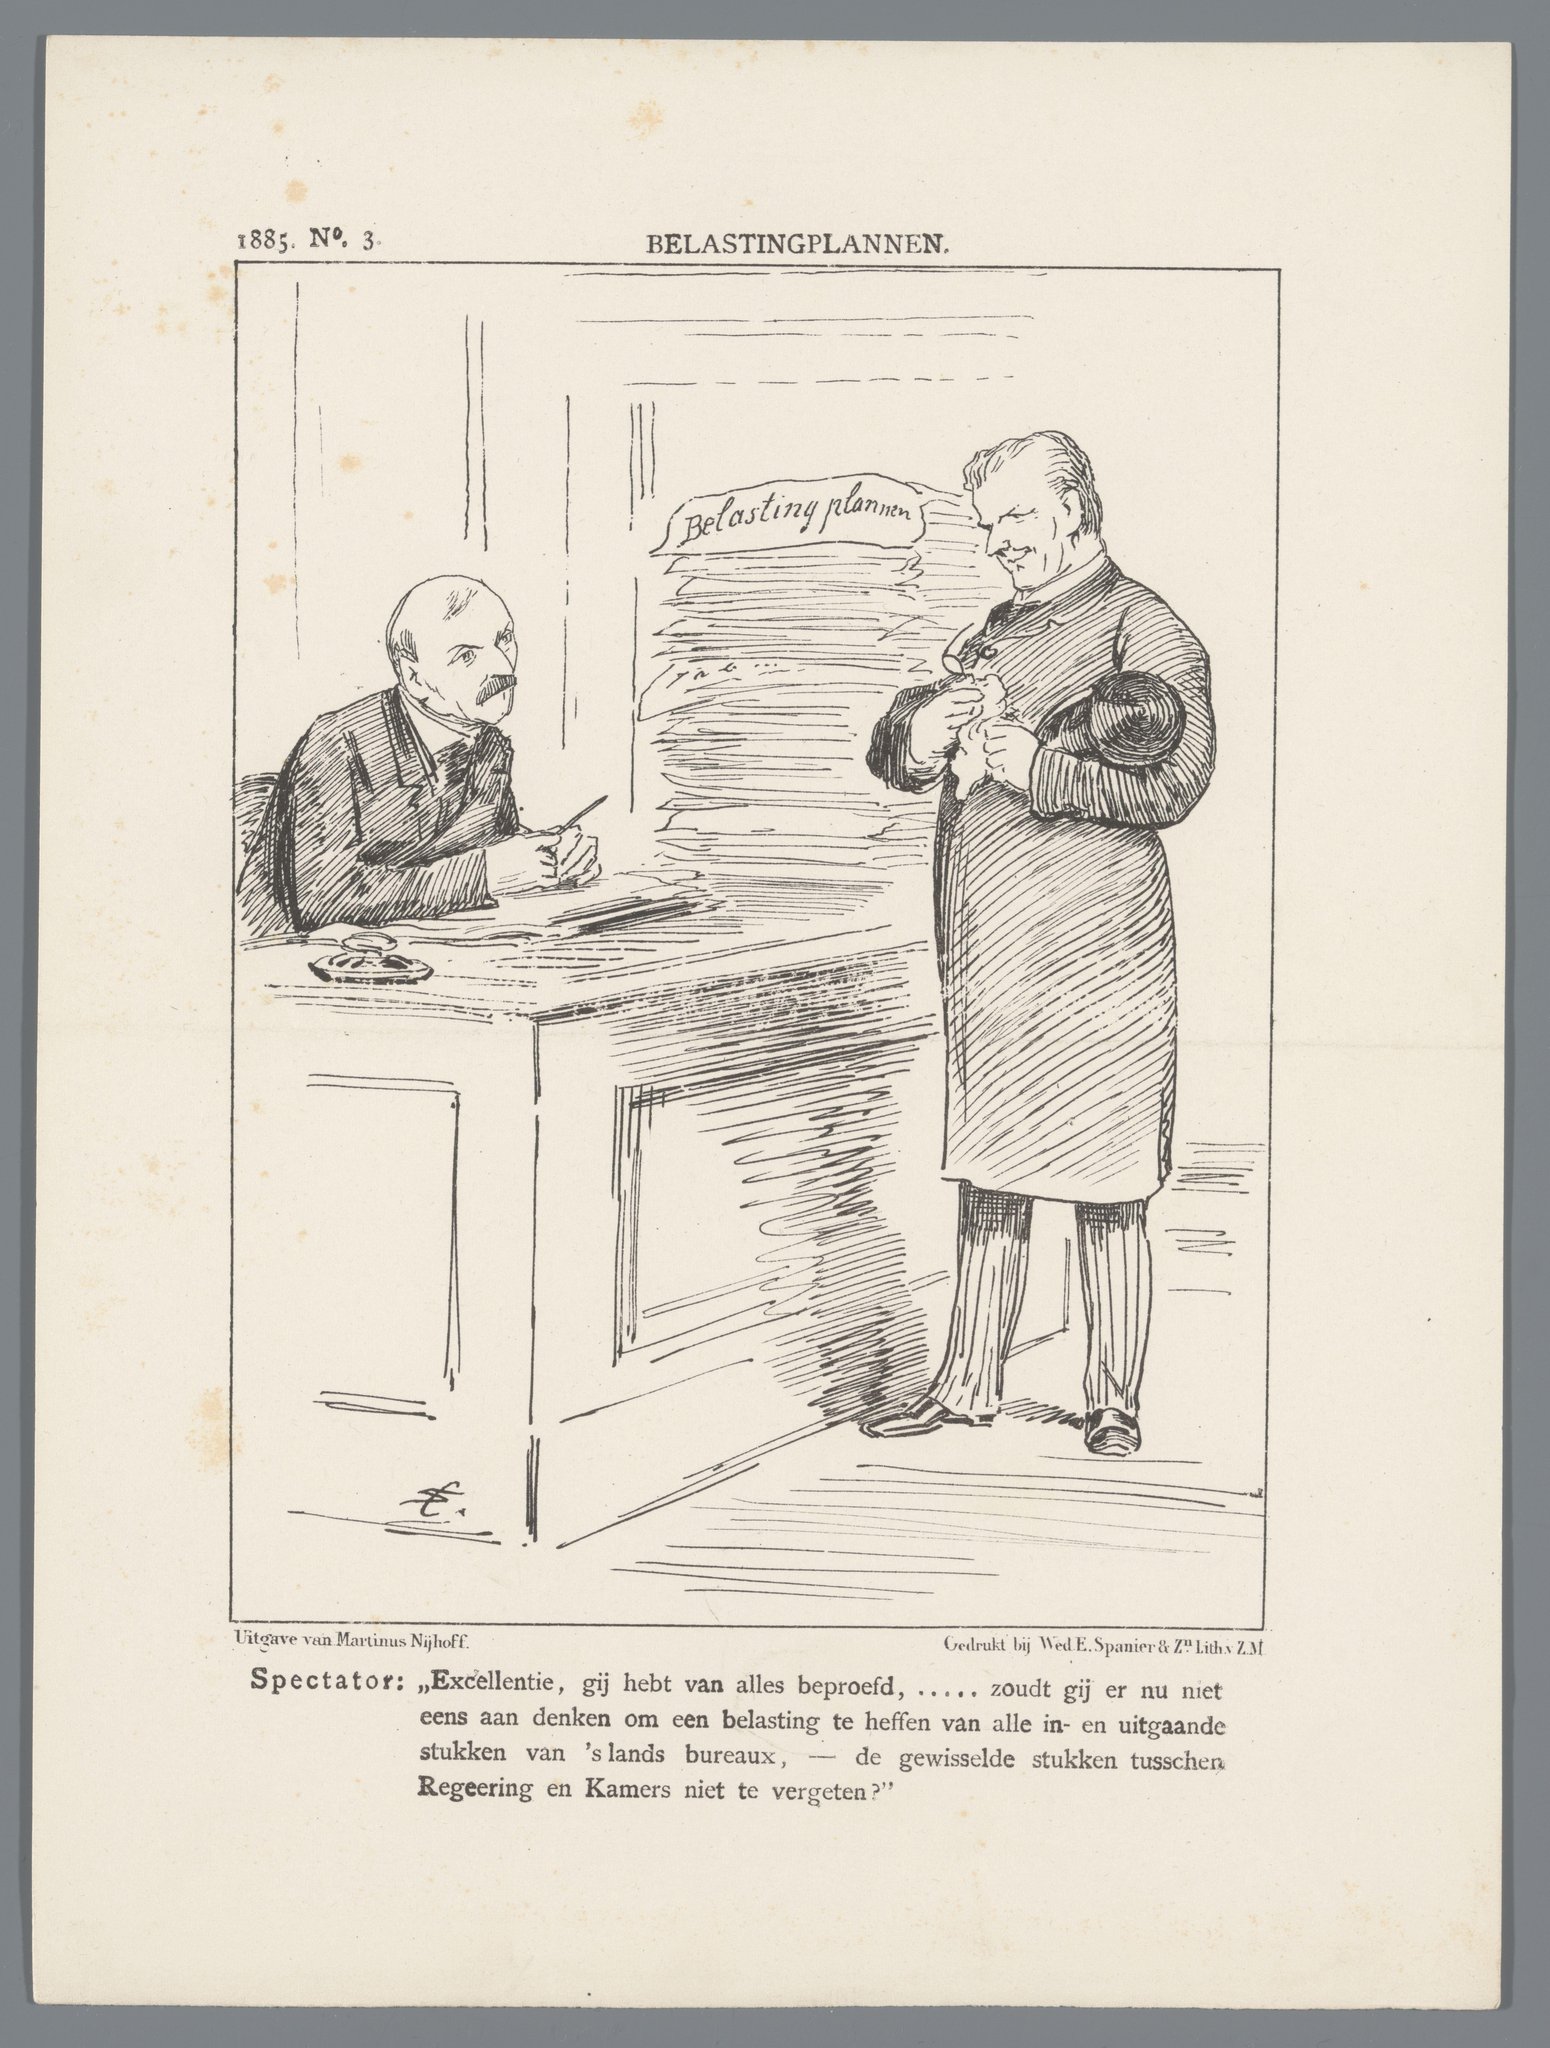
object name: print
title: Belastingplannen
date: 1885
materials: paper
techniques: lithograph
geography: netherlands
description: Spotprent over de belastingplannen van het kabinet. Plaat verschenen bij het weekblad De Nederlandsche Spectator, nr. 3, 1885.